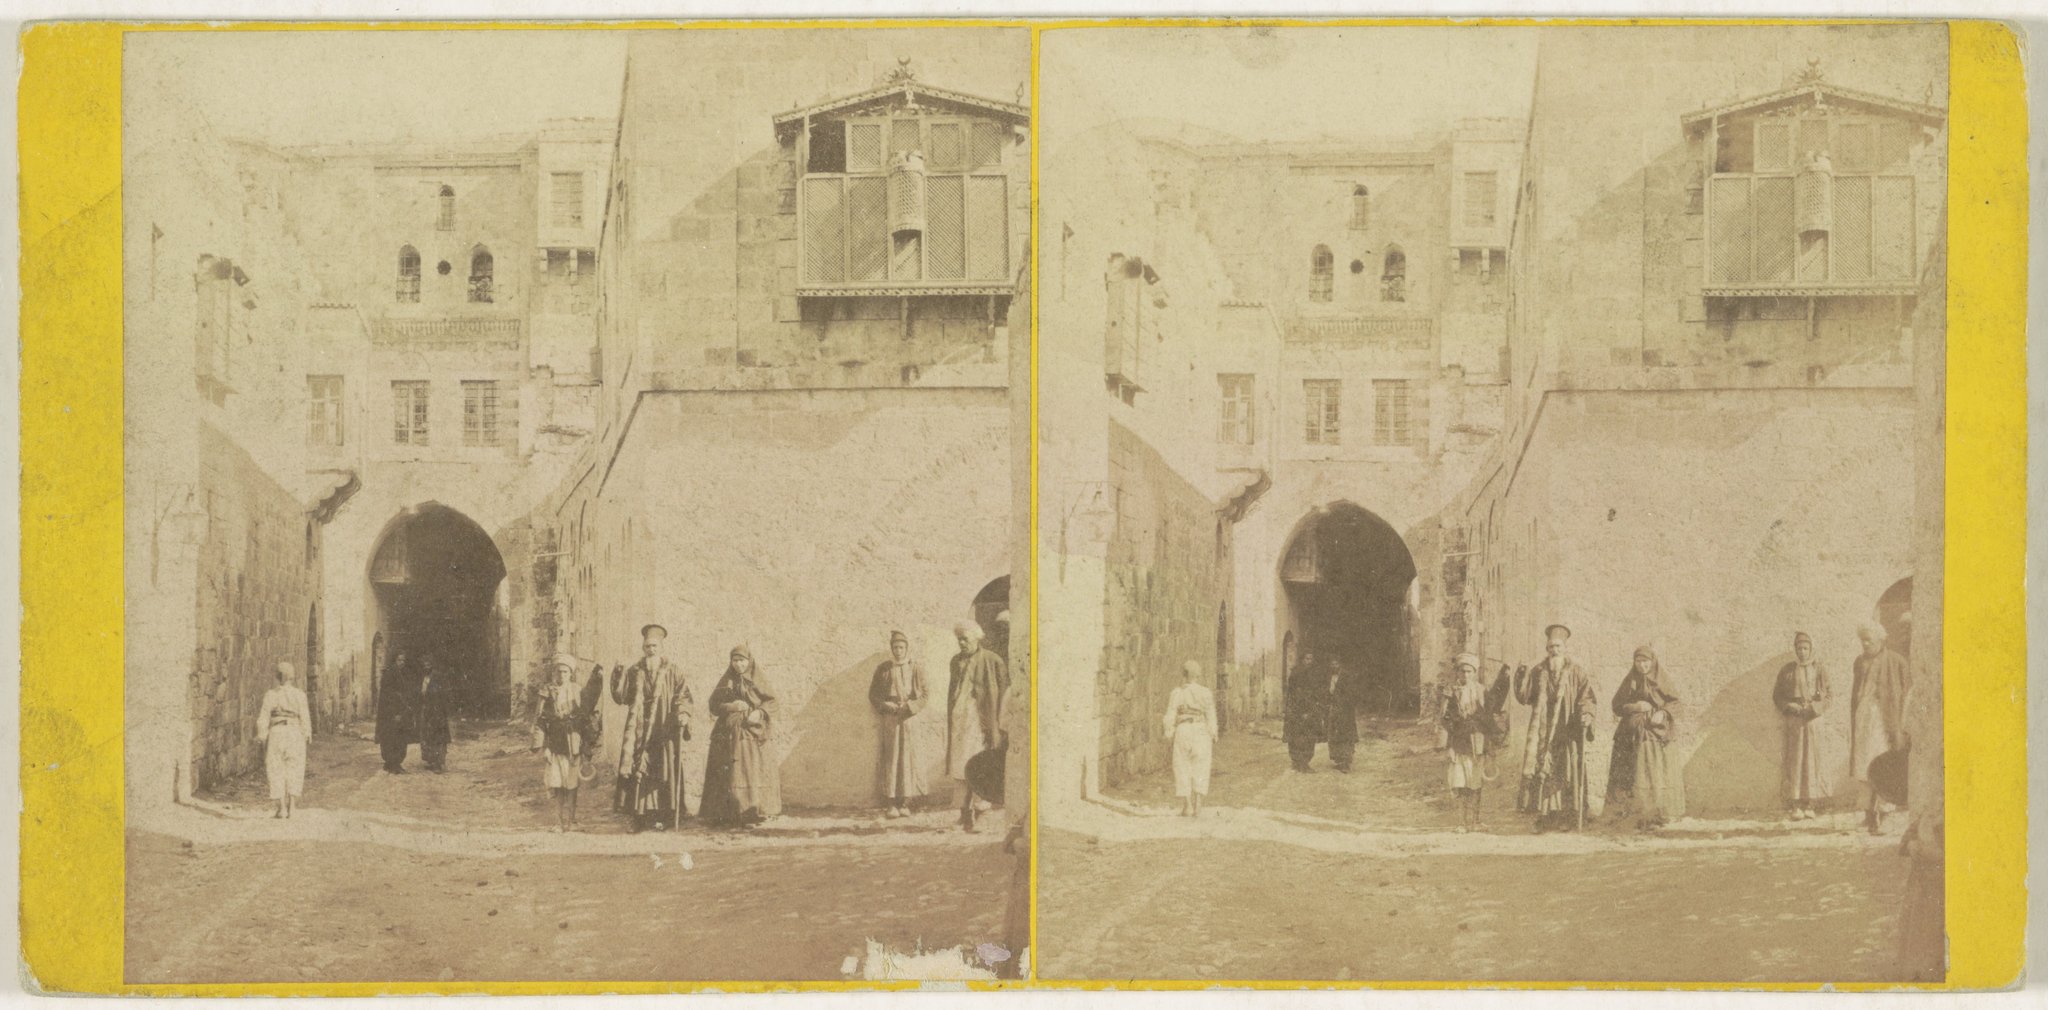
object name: stereograph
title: Straatgezicht in Jeruzalem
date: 1860-1880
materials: cardboard, paper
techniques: albumen print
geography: london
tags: street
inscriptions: number: ‘No. 289.’